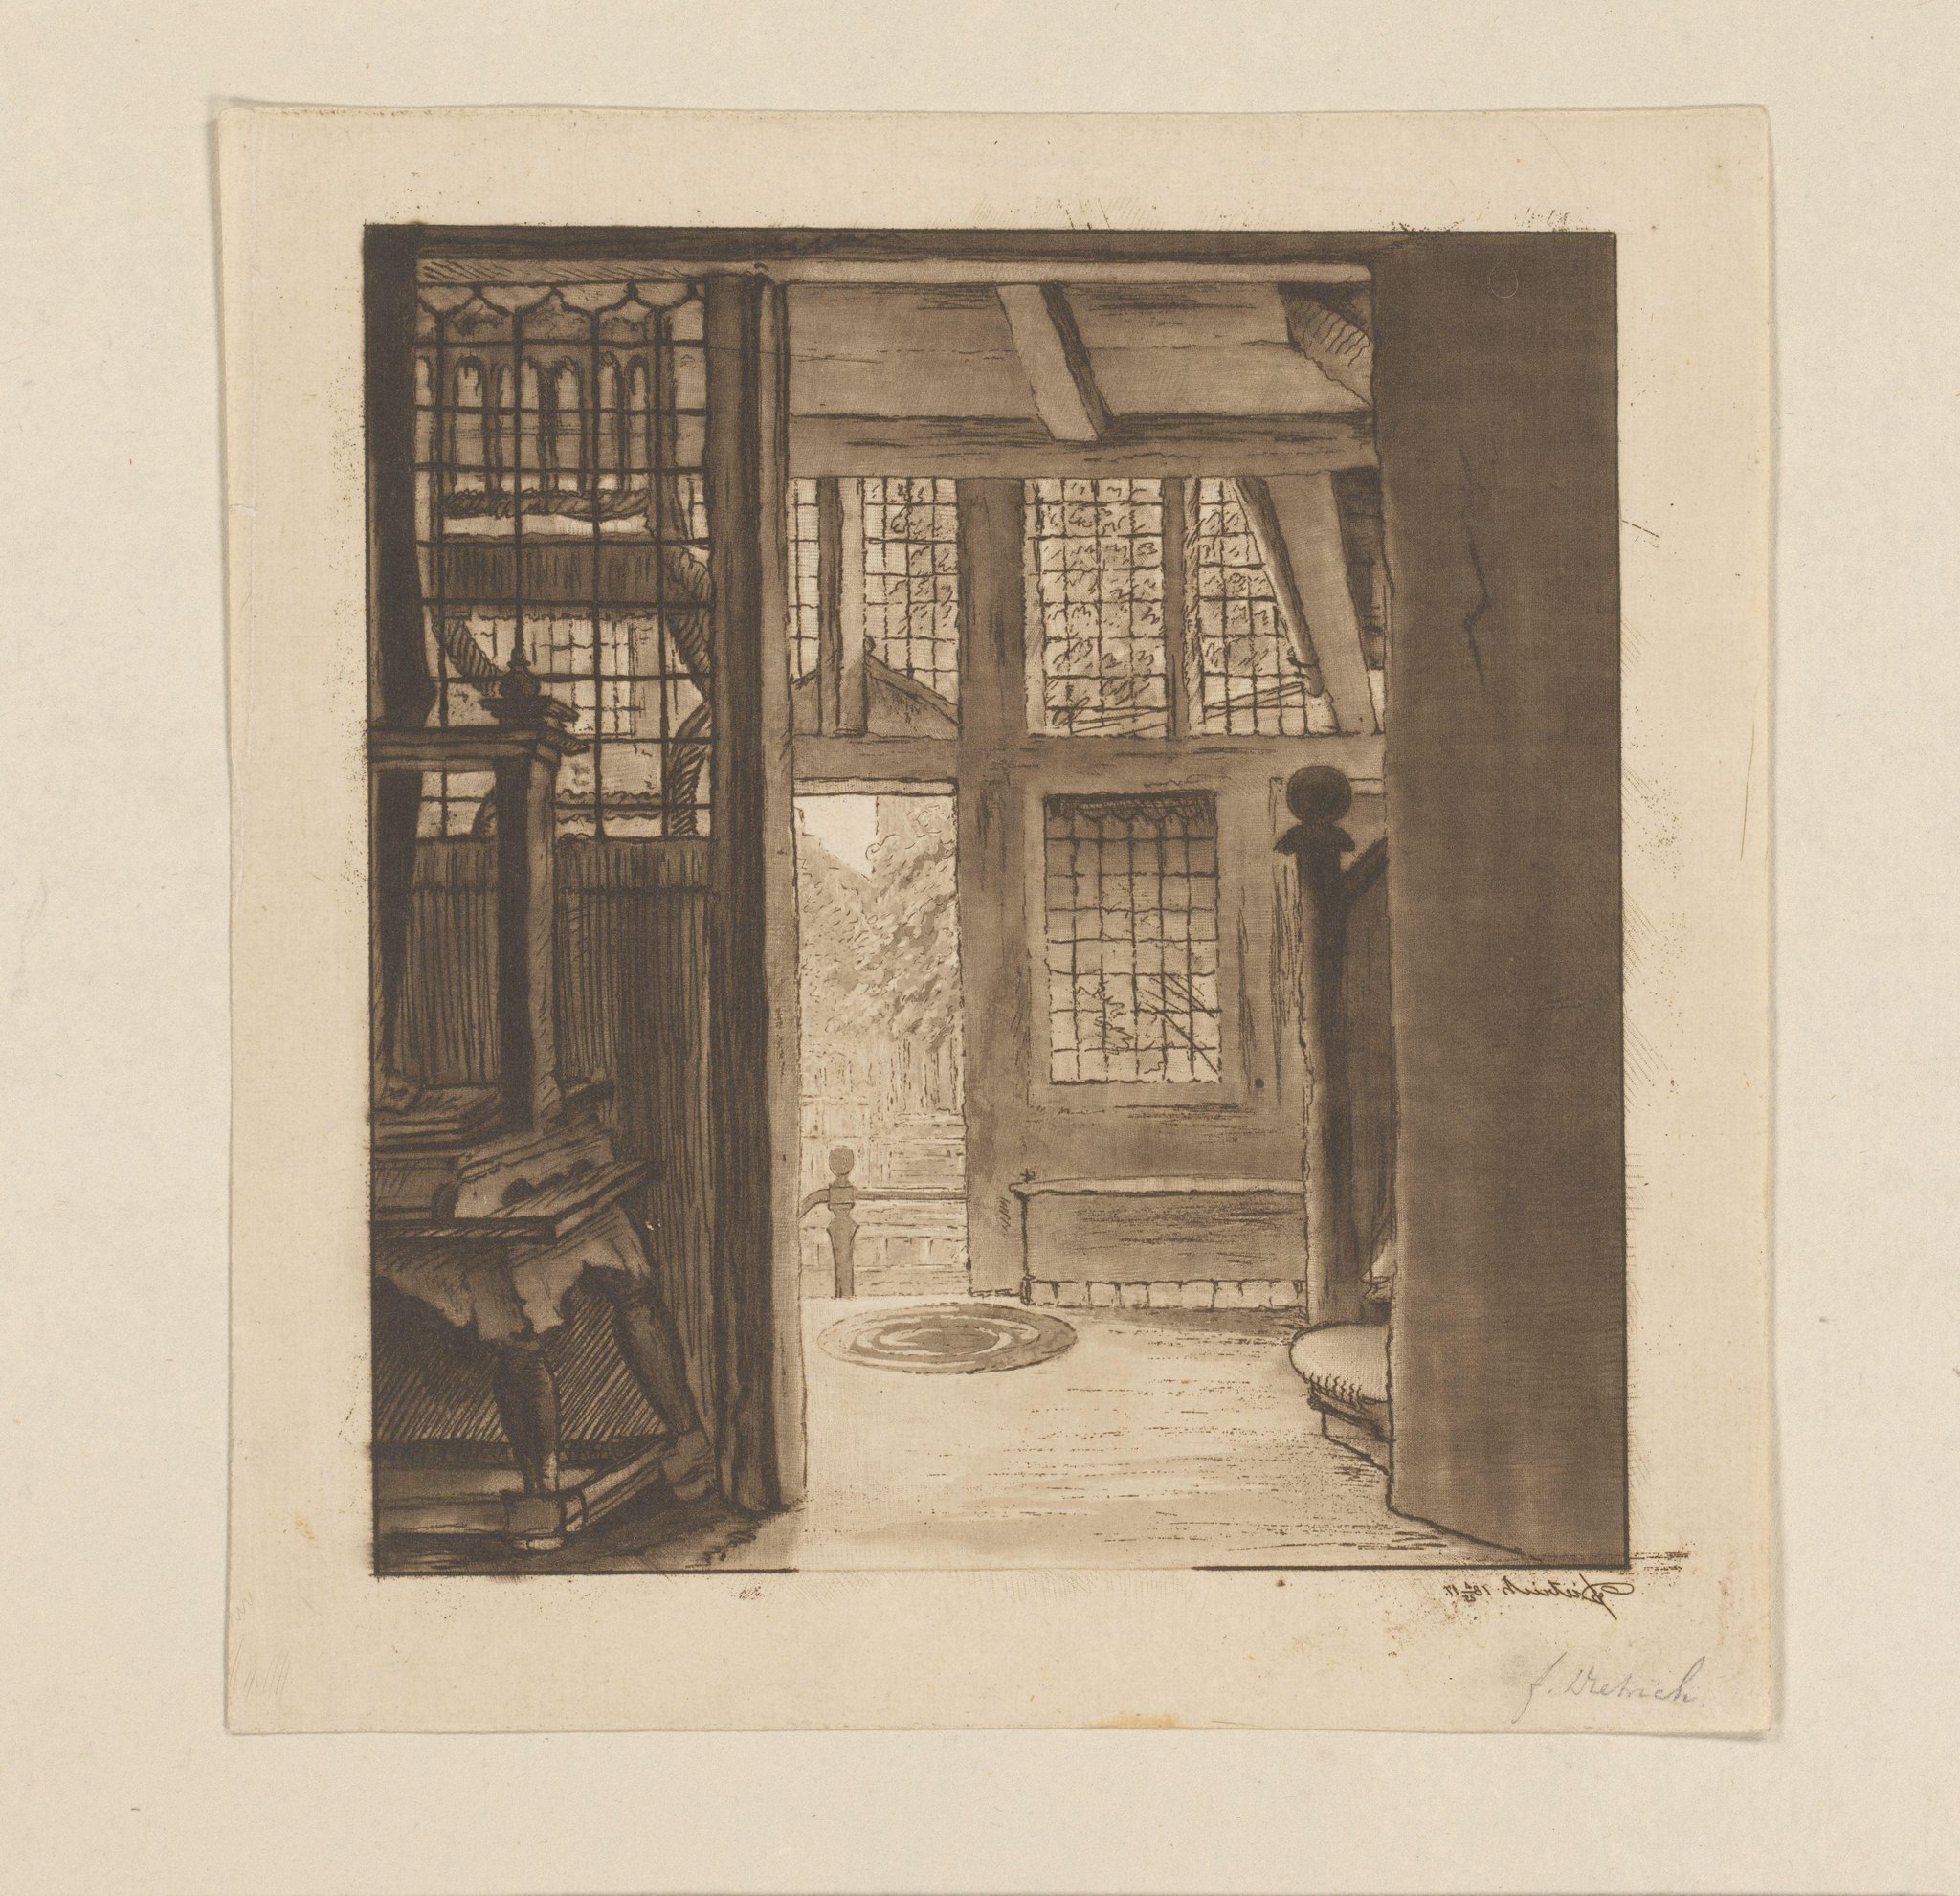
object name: print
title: Interieur van het huis van Rembrandt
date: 1817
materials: paper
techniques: etching, roulette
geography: amsterdam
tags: interior of the house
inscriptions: collector's mark: ‘RIJKS / MUSM’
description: De prent werd opgenomen in: Collection d'imitations de dessins d'après les principaux maîtres hollandais et flamands, Londen, C. Josi, 1821.